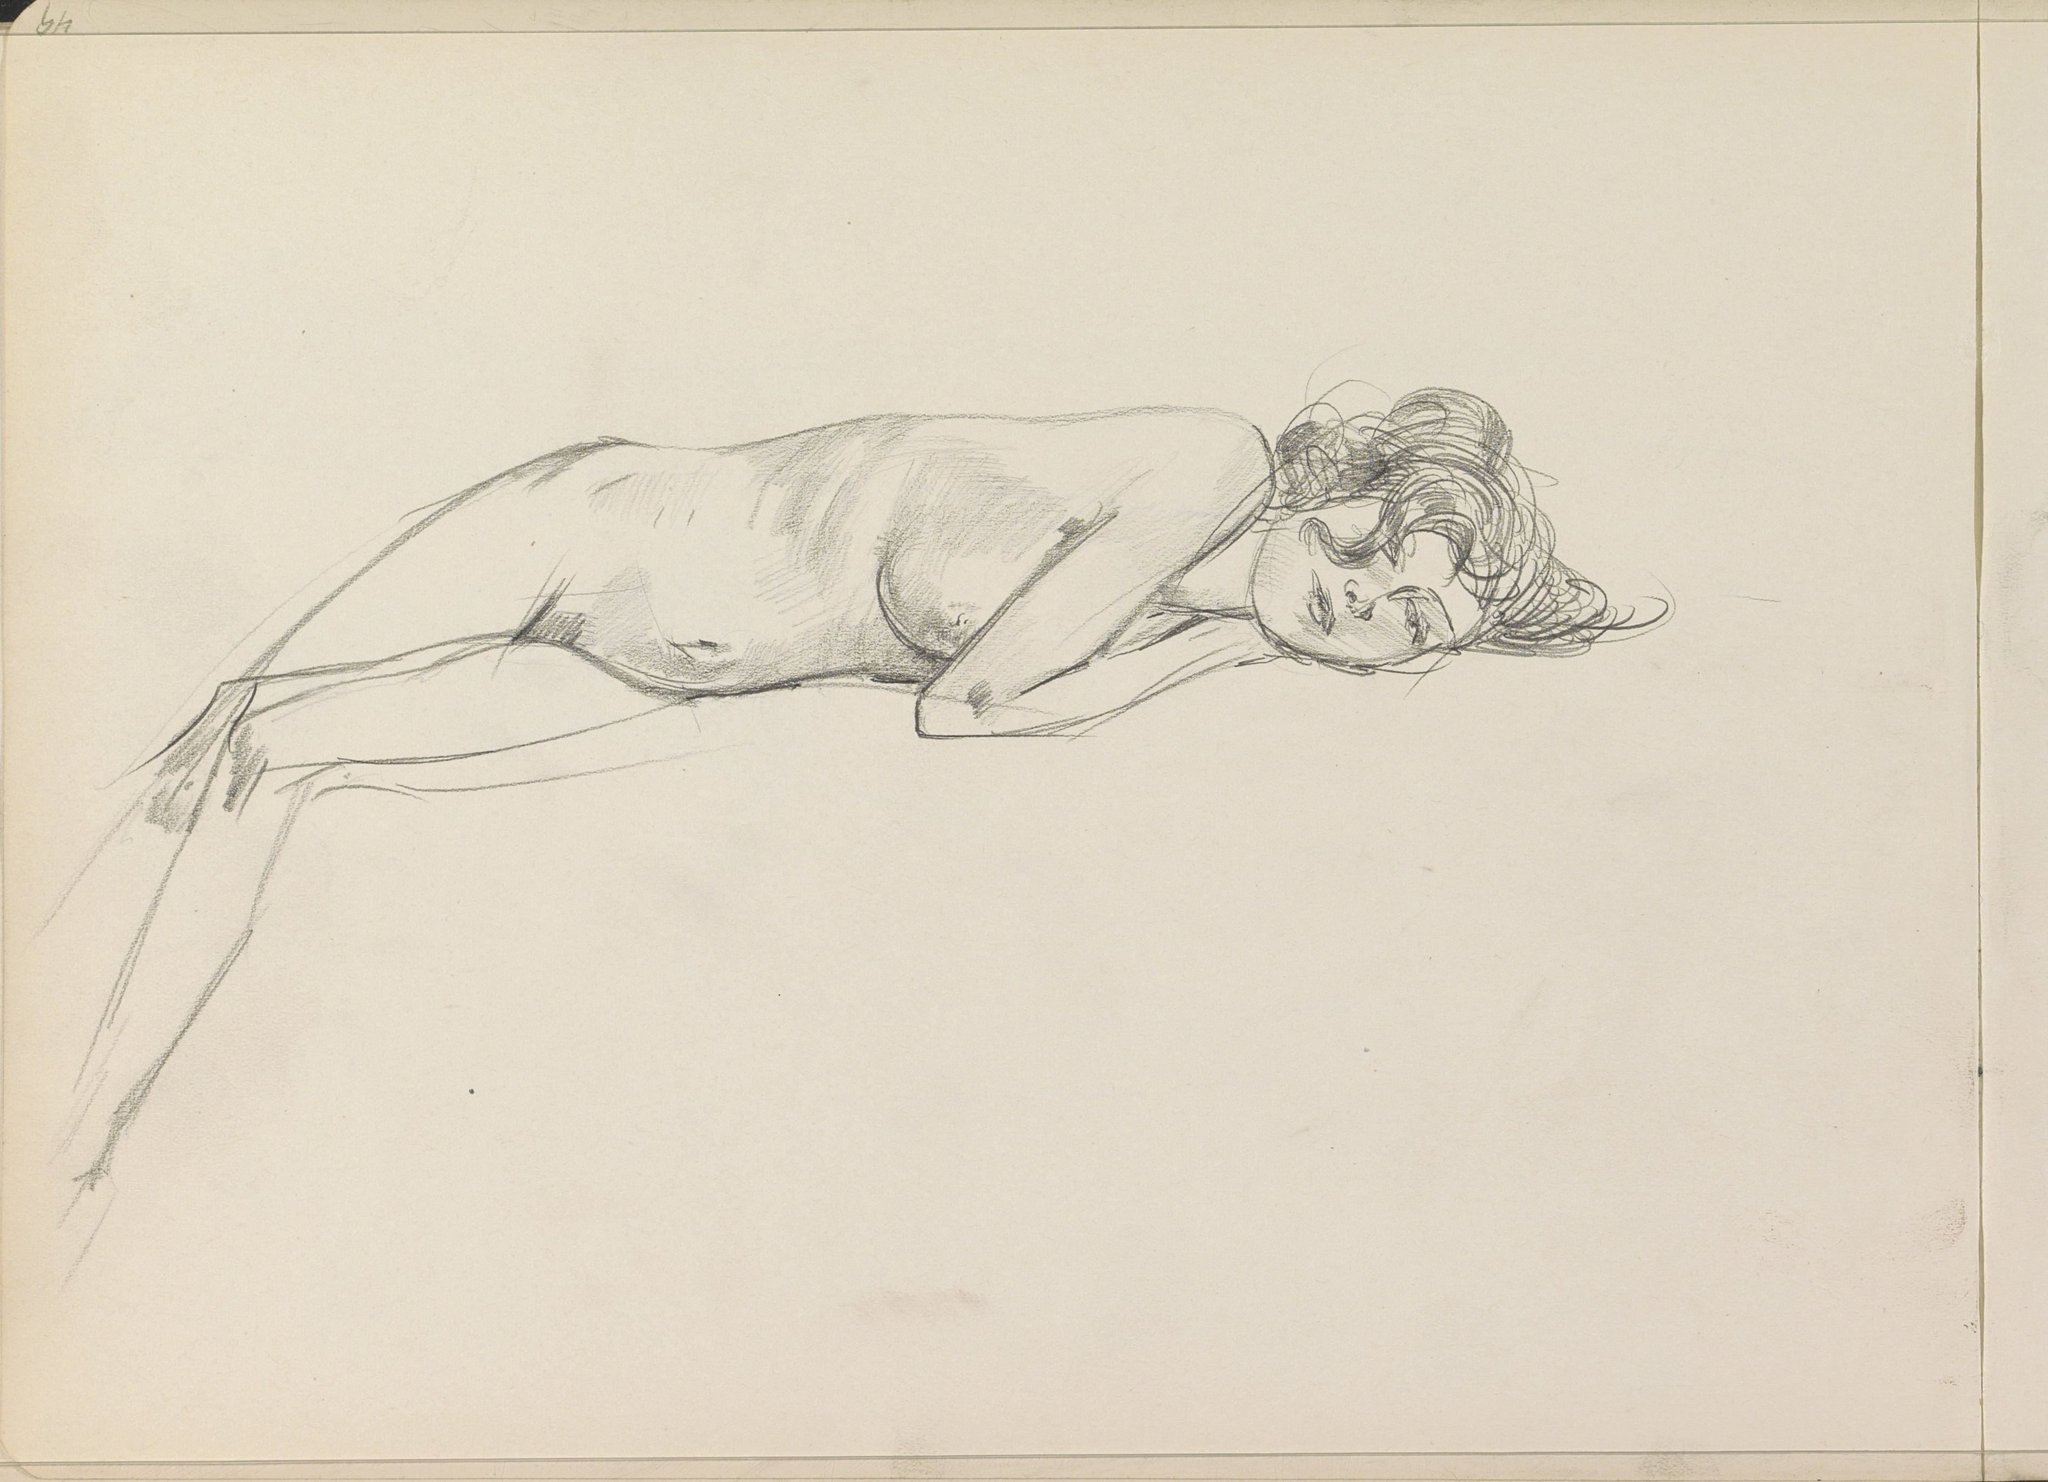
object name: sketchbook leaf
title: Liggende naakte vrouw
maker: isaac israels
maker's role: draughtsman, painter, print maker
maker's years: 1865-1934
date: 1915-1934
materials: paper, pencil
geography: the hague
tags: lying figure - aa - female human figure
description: Blad 18 verso uit schetsboek VI met 33 bladen.